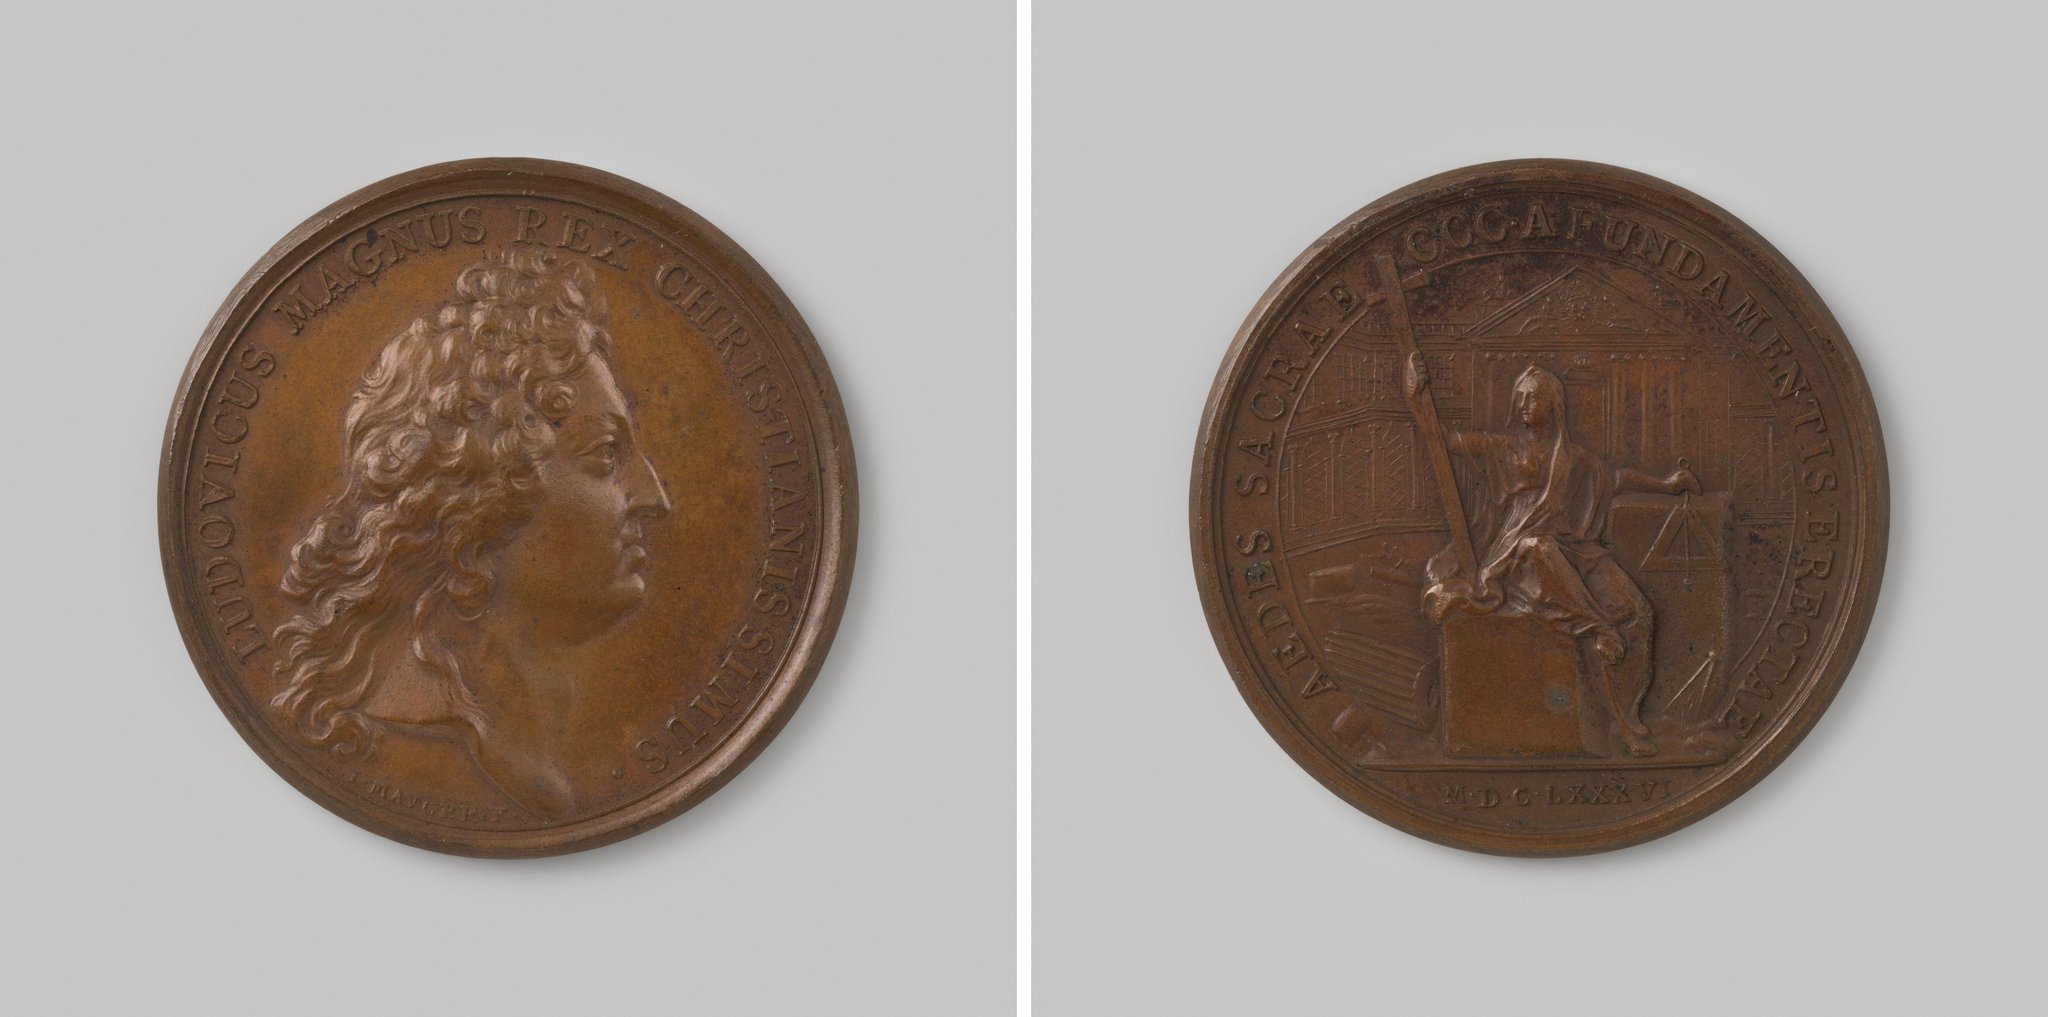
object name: history medal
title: Oprichting van driehonderd nieuwe kerken in Frankrijk 1686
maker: jean mauger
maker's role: medailleur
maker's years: 1648-1722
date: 1686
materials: copper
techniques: striking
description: Koperen penning, op de voorzijde het portret van Koning Lodewijk XIV naar rechts met omschrift, op de keerzijde een gesluierde vrouw met lang kruis en schietlood zittend op een steenblok waarachter een gebouw en bouwfragmenten, met omschrift en afsnedetekst.